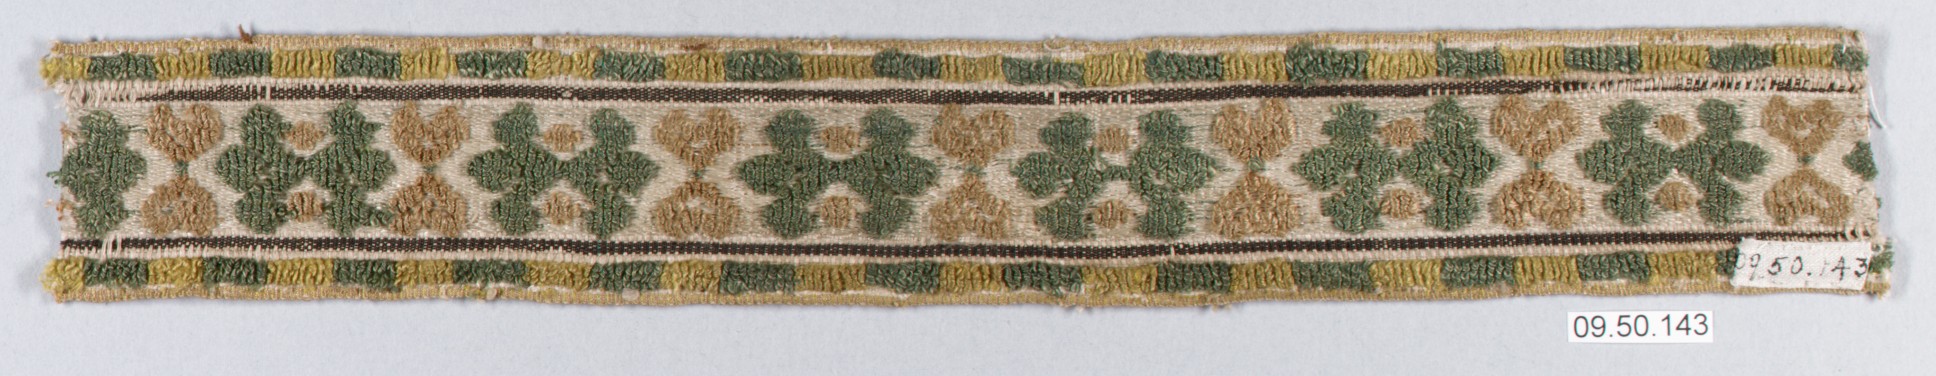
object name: galloon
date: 1701-1800